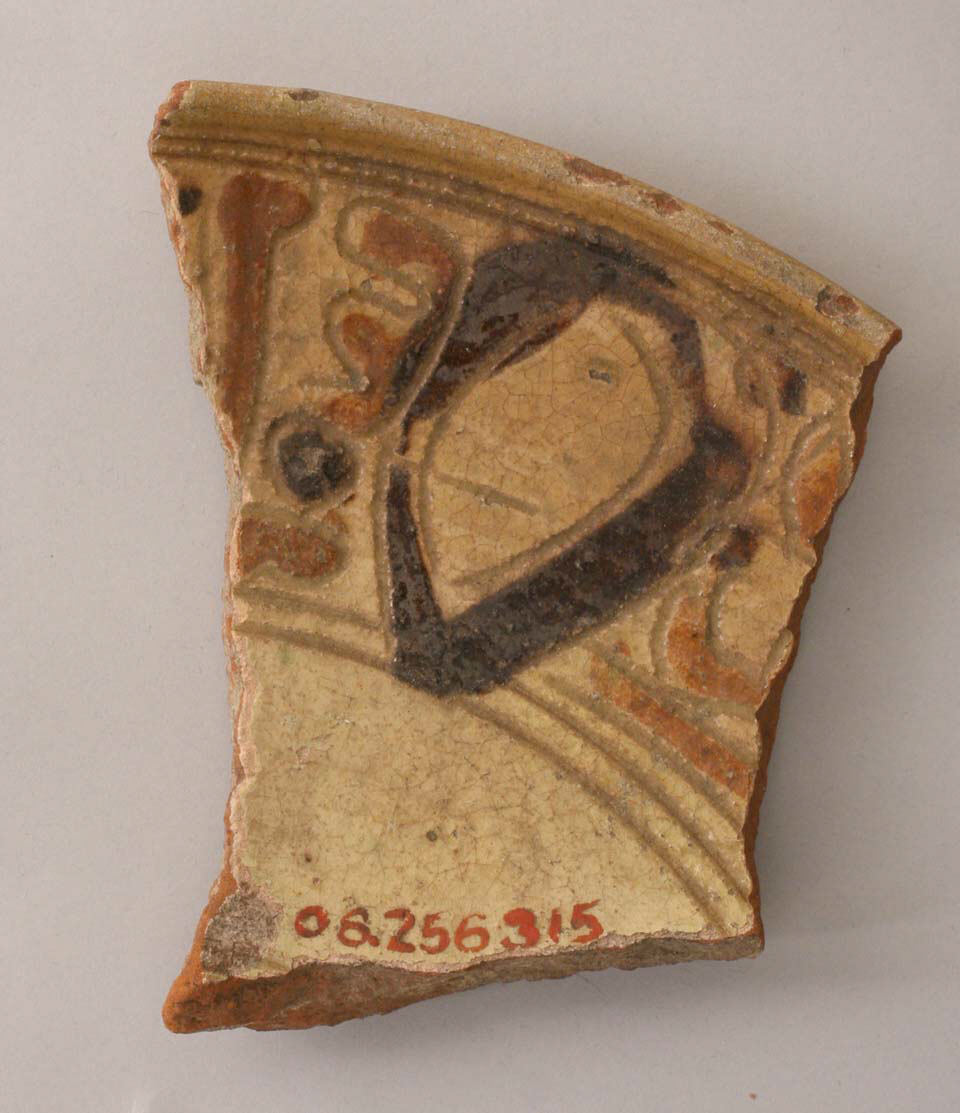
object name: fragment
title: Ceramic Fragment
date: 1301-1500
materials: earthenware, glaze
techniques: coloring, incising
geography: egypt